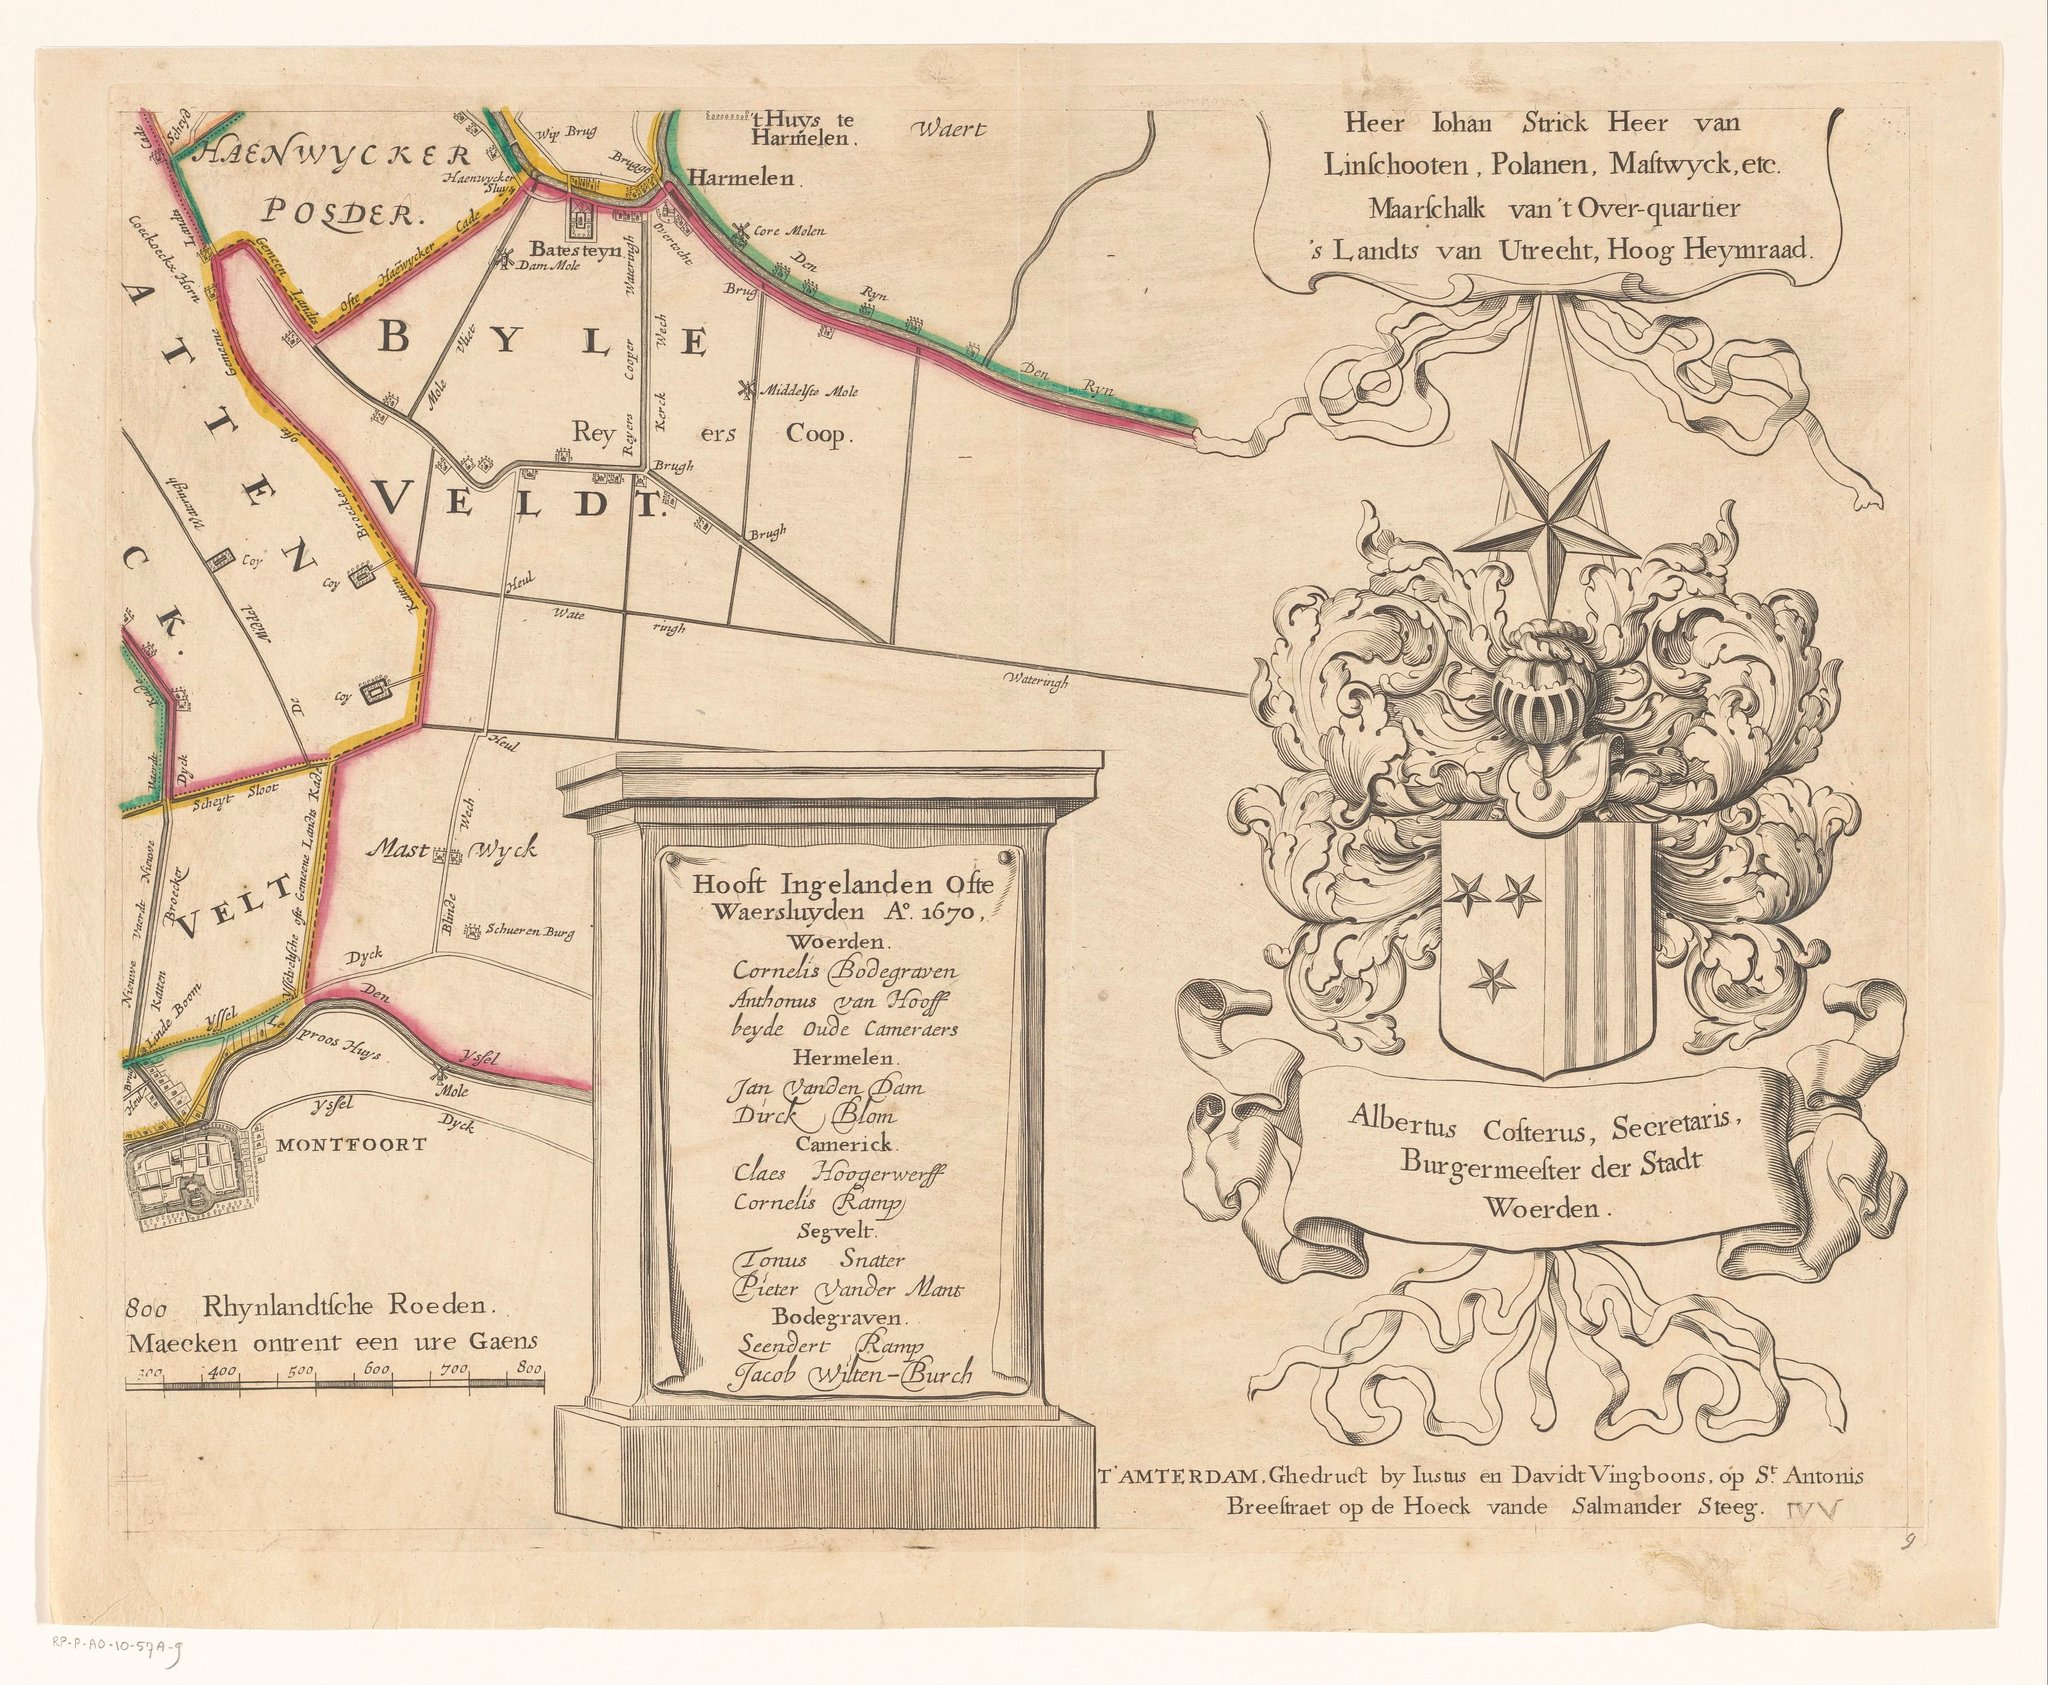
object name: map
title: Kaart van het Hoogheemraadschap van Woerden (negende deel)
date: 1670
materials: paper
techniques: engraving, hand coloring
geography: amsterdam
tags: maps of separate countries or regions, armorial bearing, heraldry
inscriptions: collector's mark: Lugt 2228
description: Negende deel (onder rechts) van een kaart van het Hoogheemraadschap van Woerden.